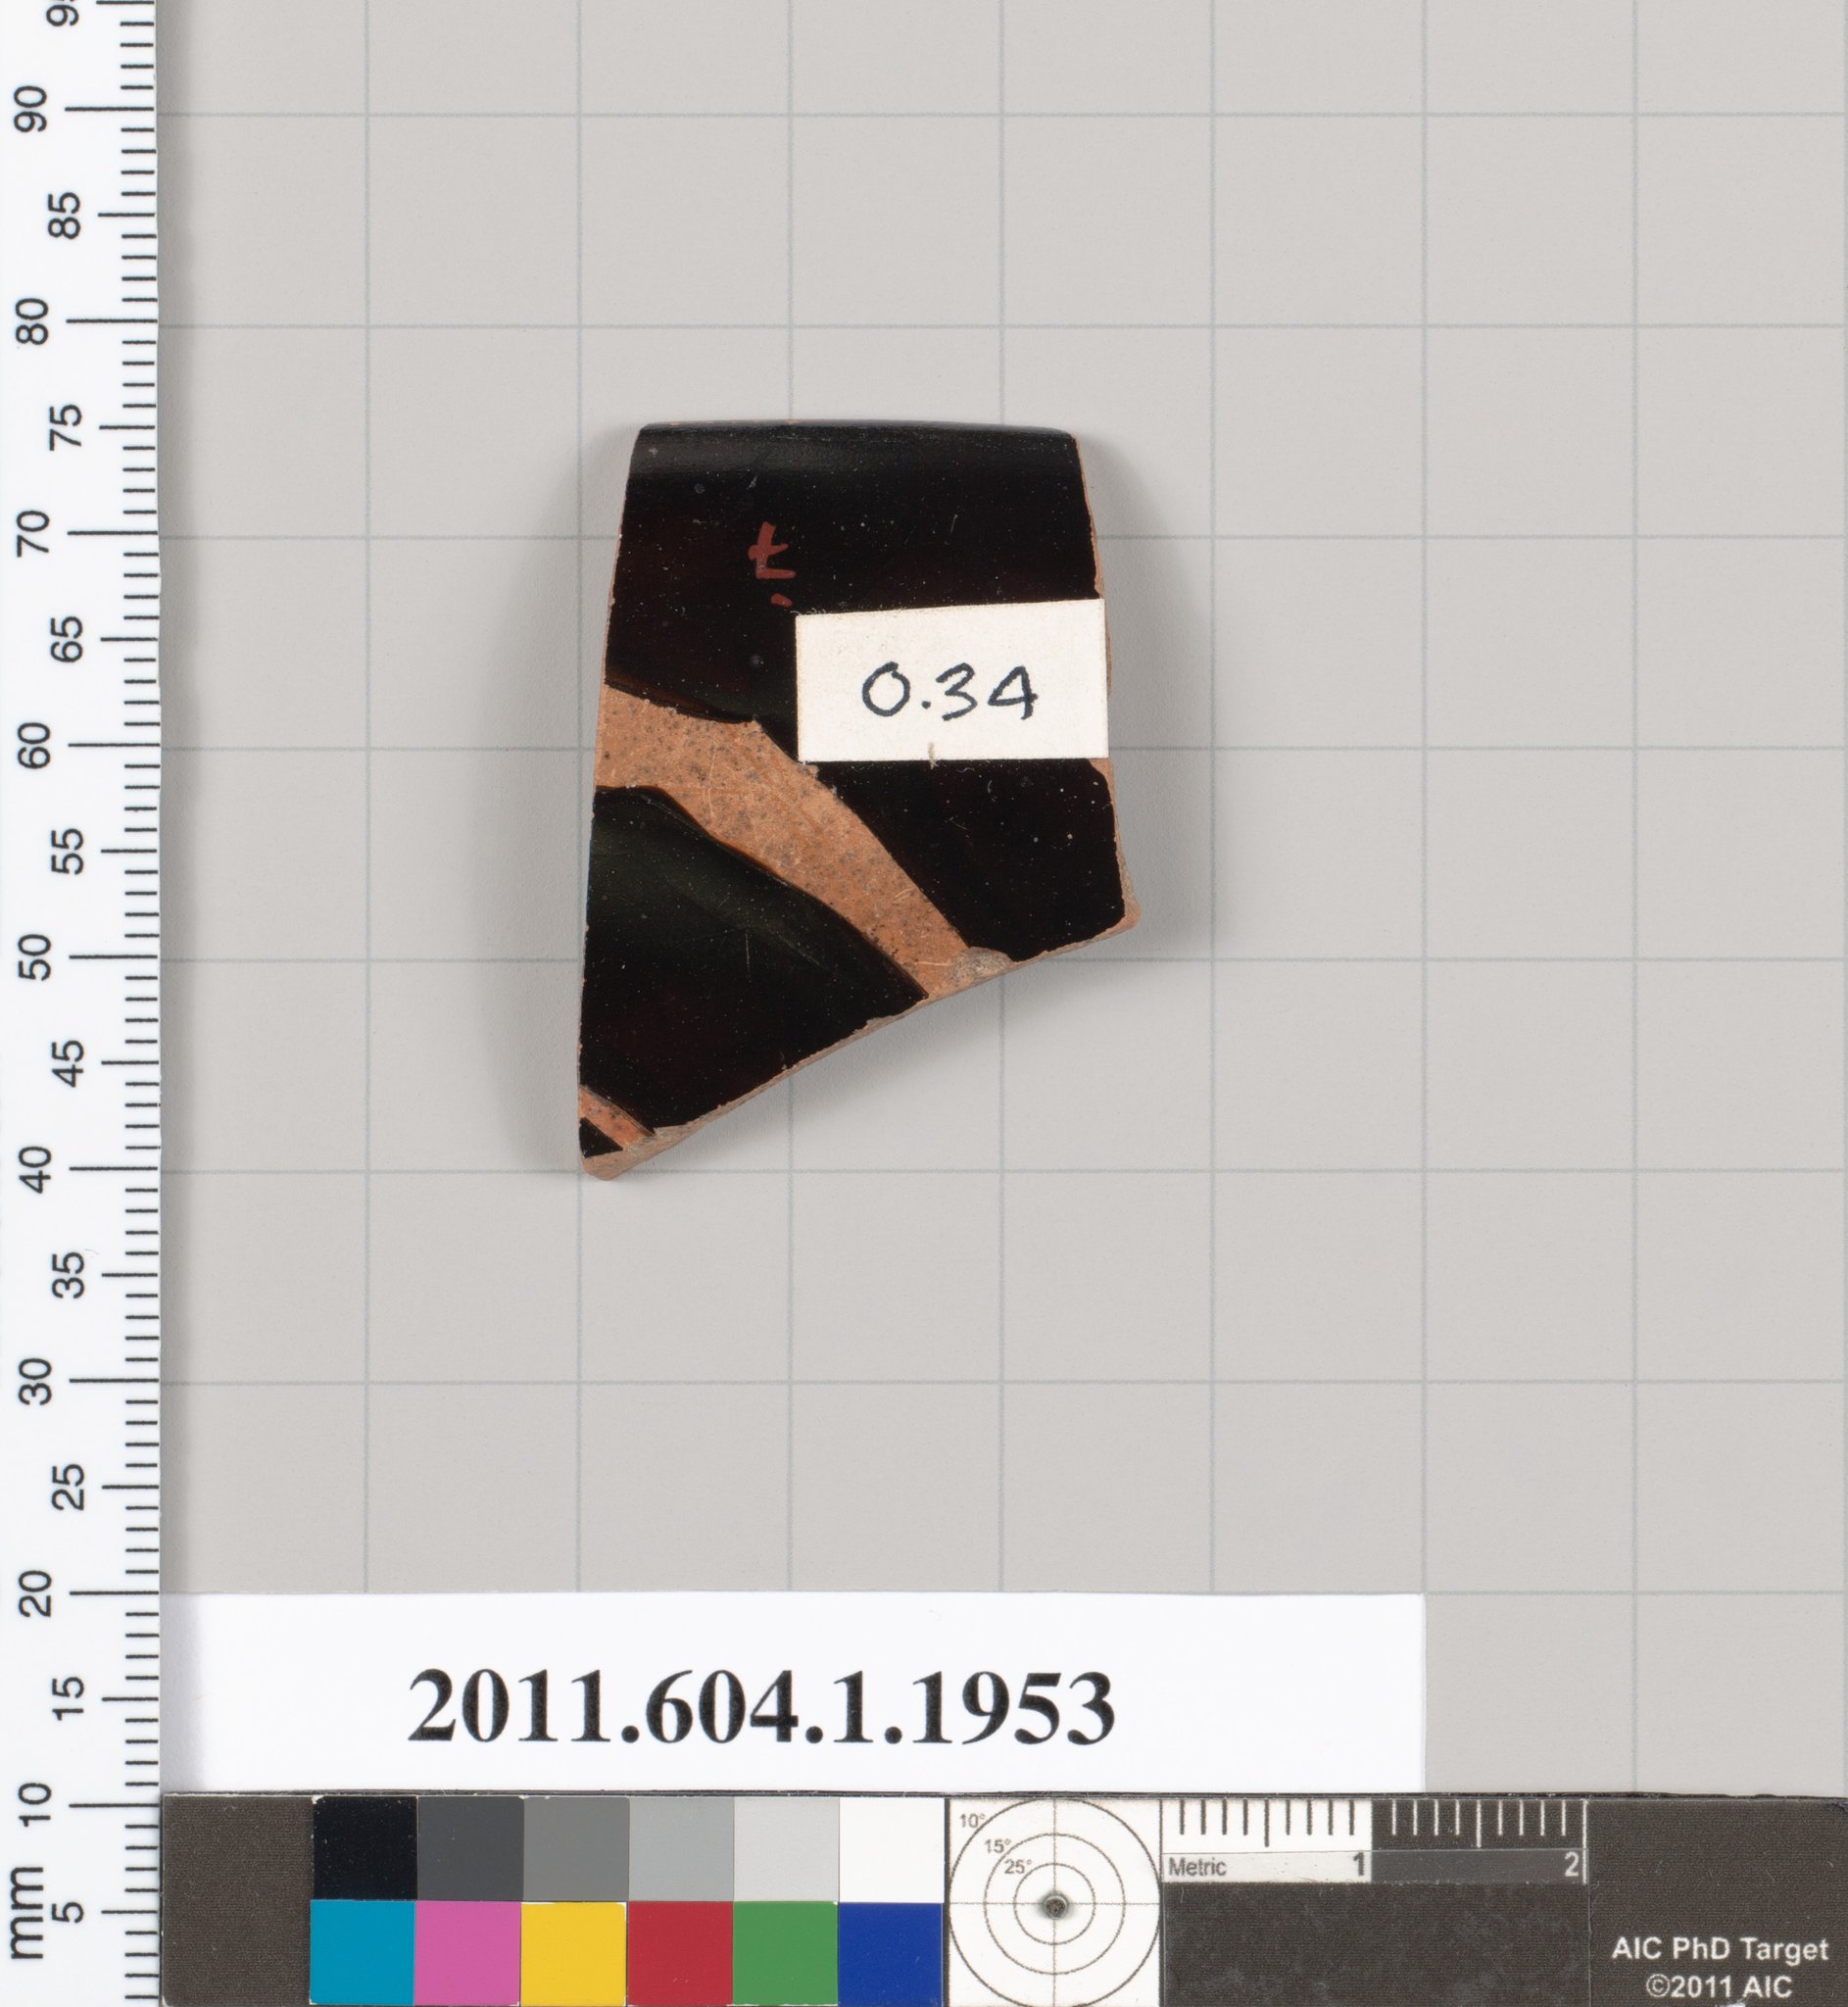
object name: kylix fragment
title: Terracotta rim fragment of a kylix (drinking cup)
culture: greek, attic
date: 475-451 BCE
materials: terracotta